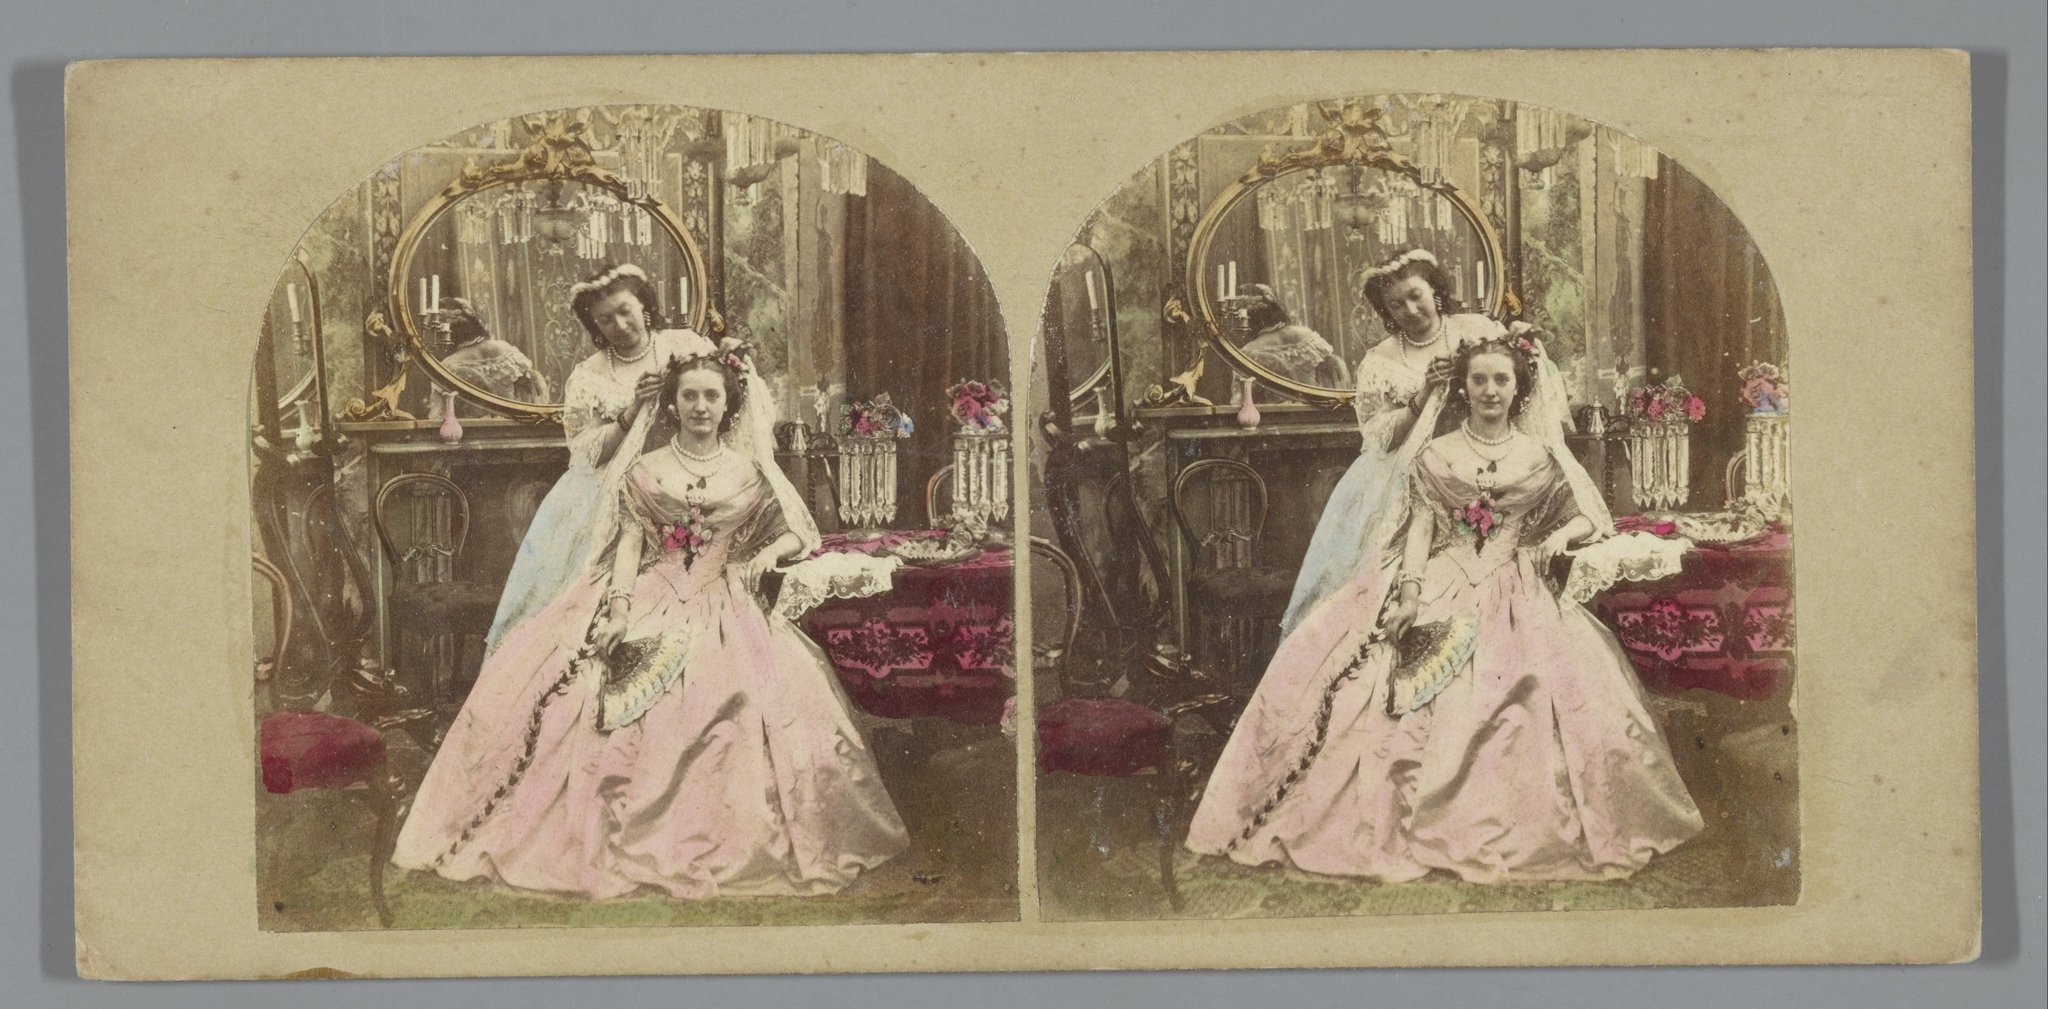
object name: stereograph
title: The Bride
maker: Anonymous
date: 1852-1863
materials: cardboard, paper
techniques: albumen print, hand coloring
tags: dressing the bride, interior of the house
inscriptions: inscription: ‘Lp. 63.’